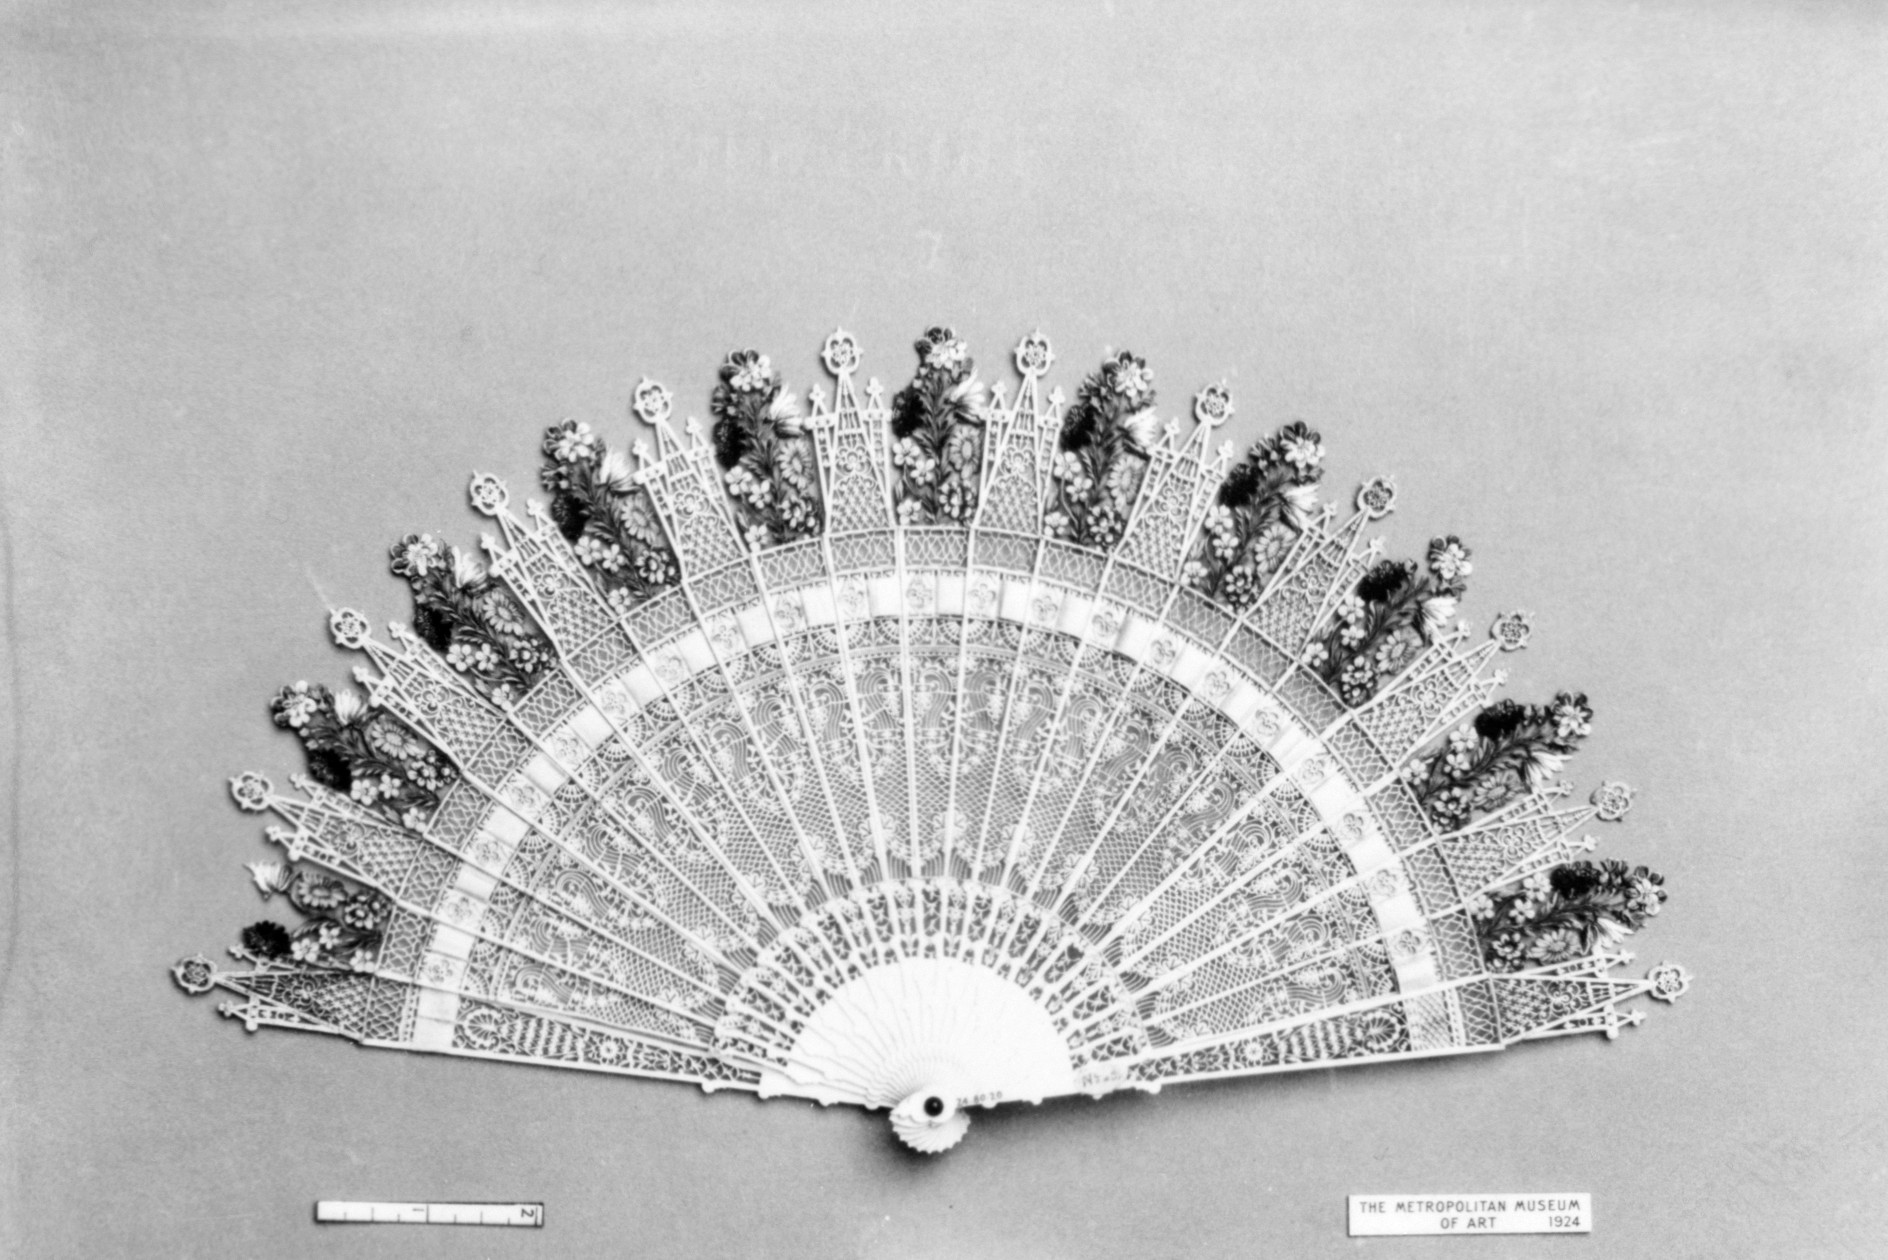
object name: fan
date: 1830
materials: gilt, ivory